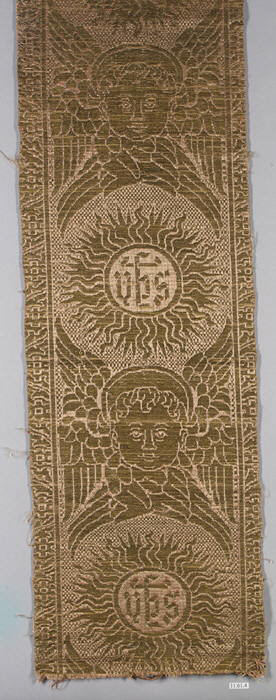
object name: orphrey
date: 1401-1600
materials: linen, metal thread, silk